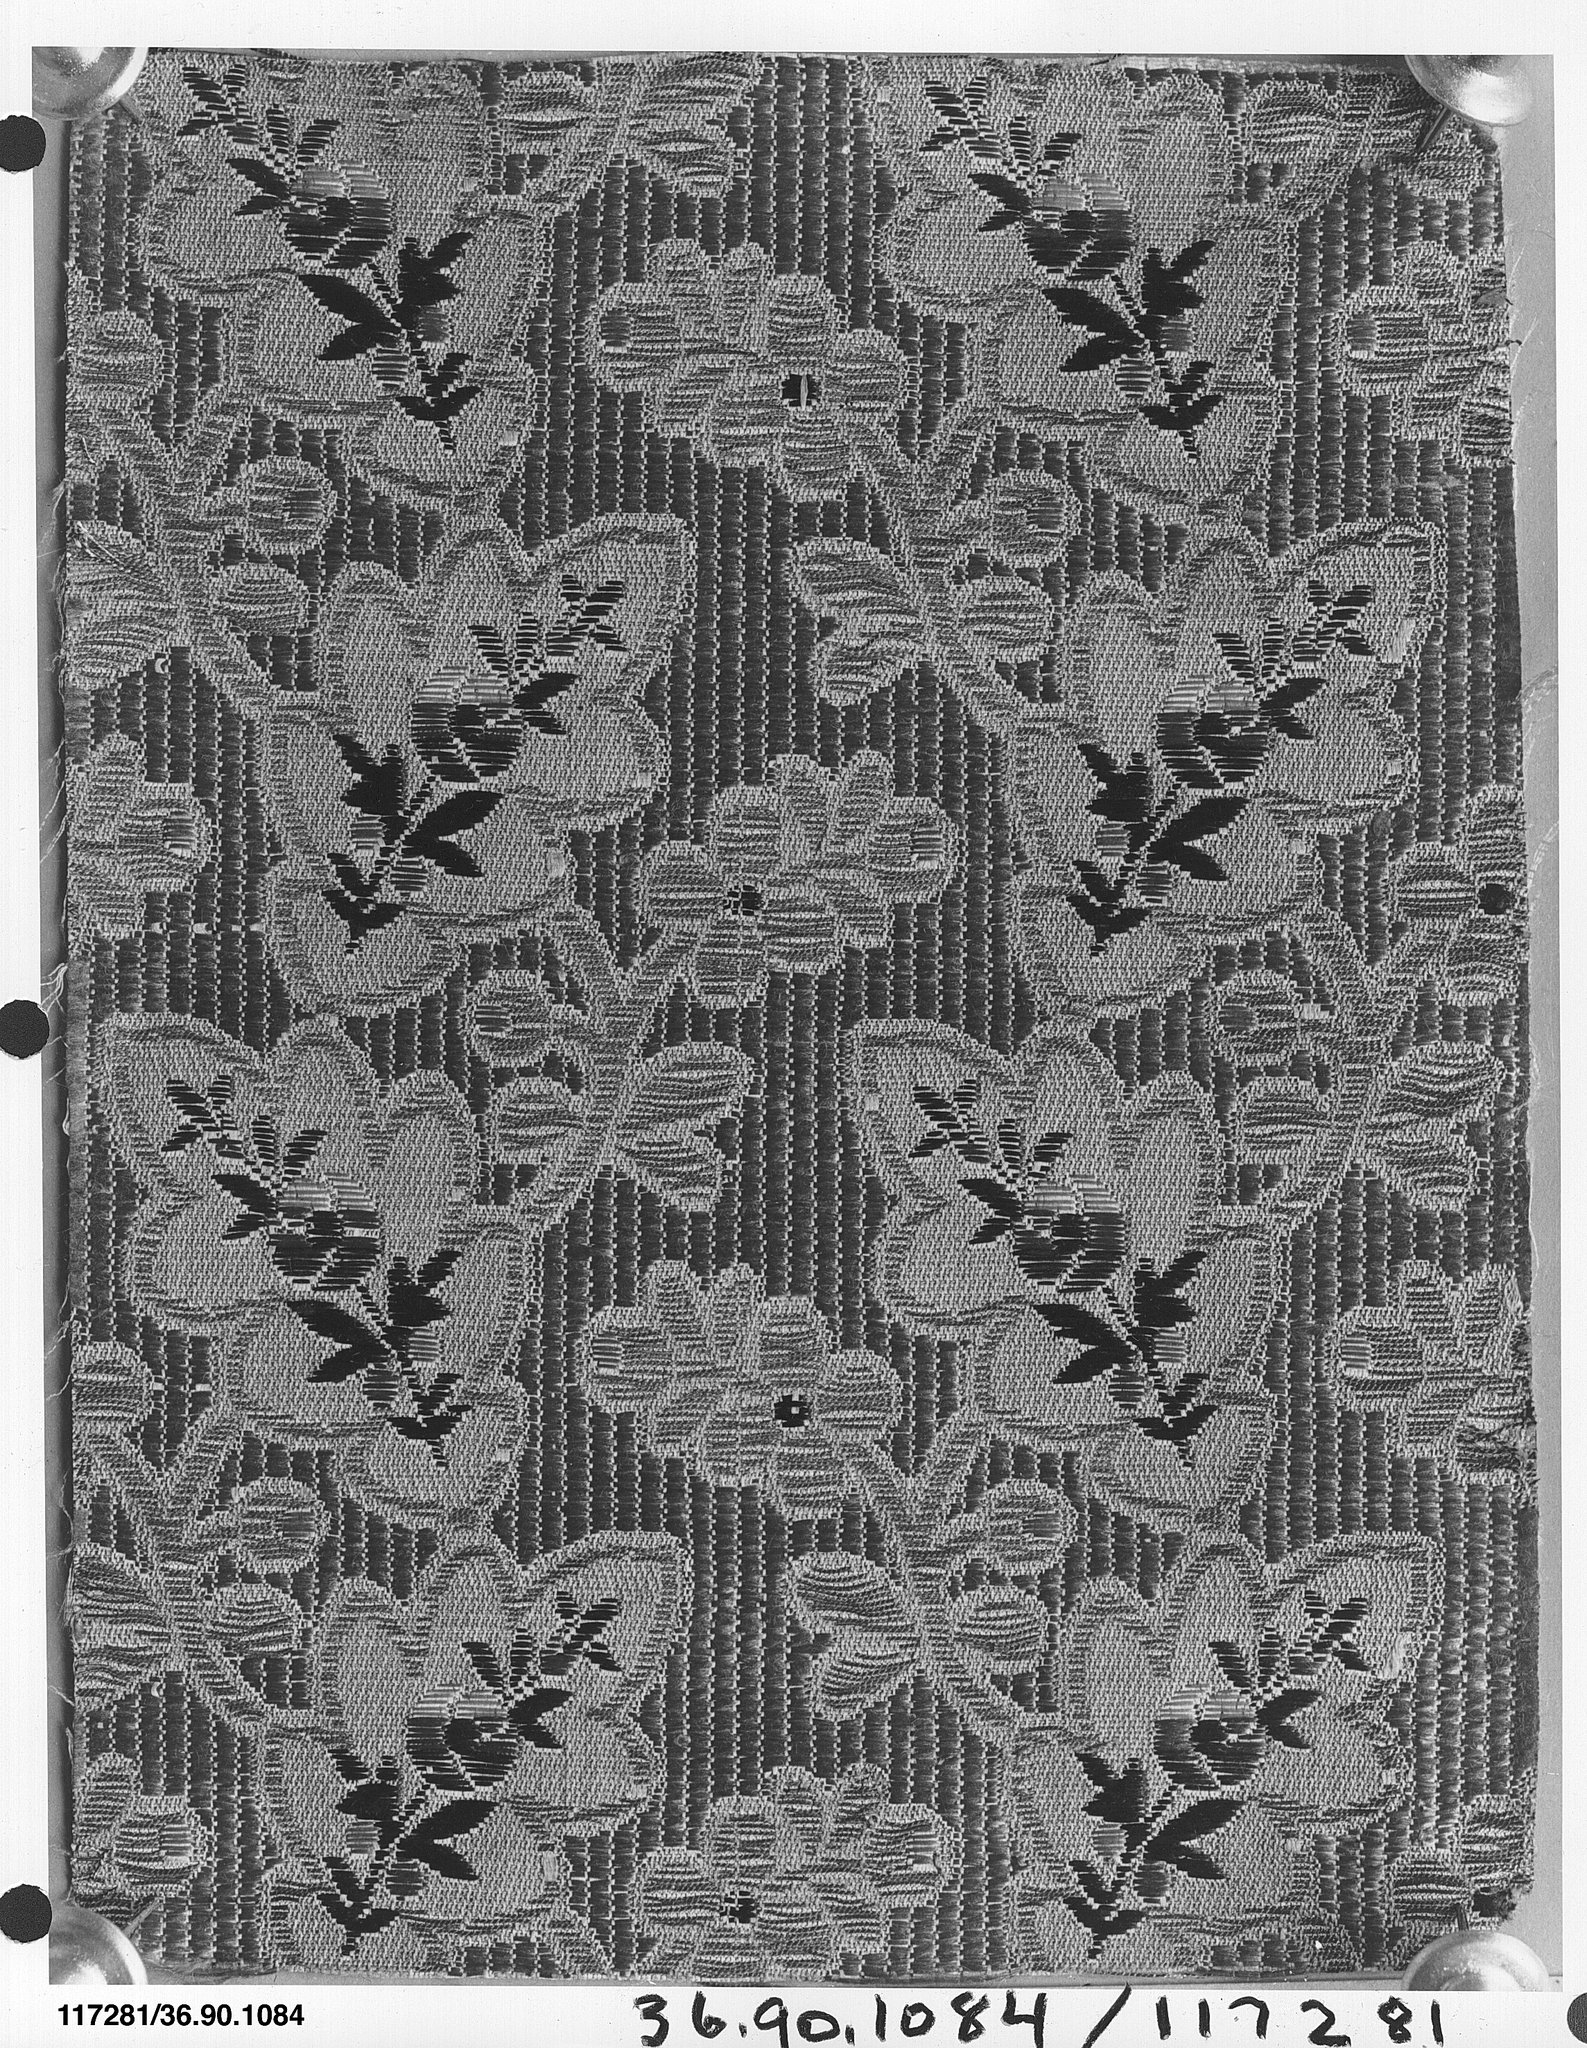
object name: piece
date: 1701-1900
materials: metal thread, silk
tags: flowers